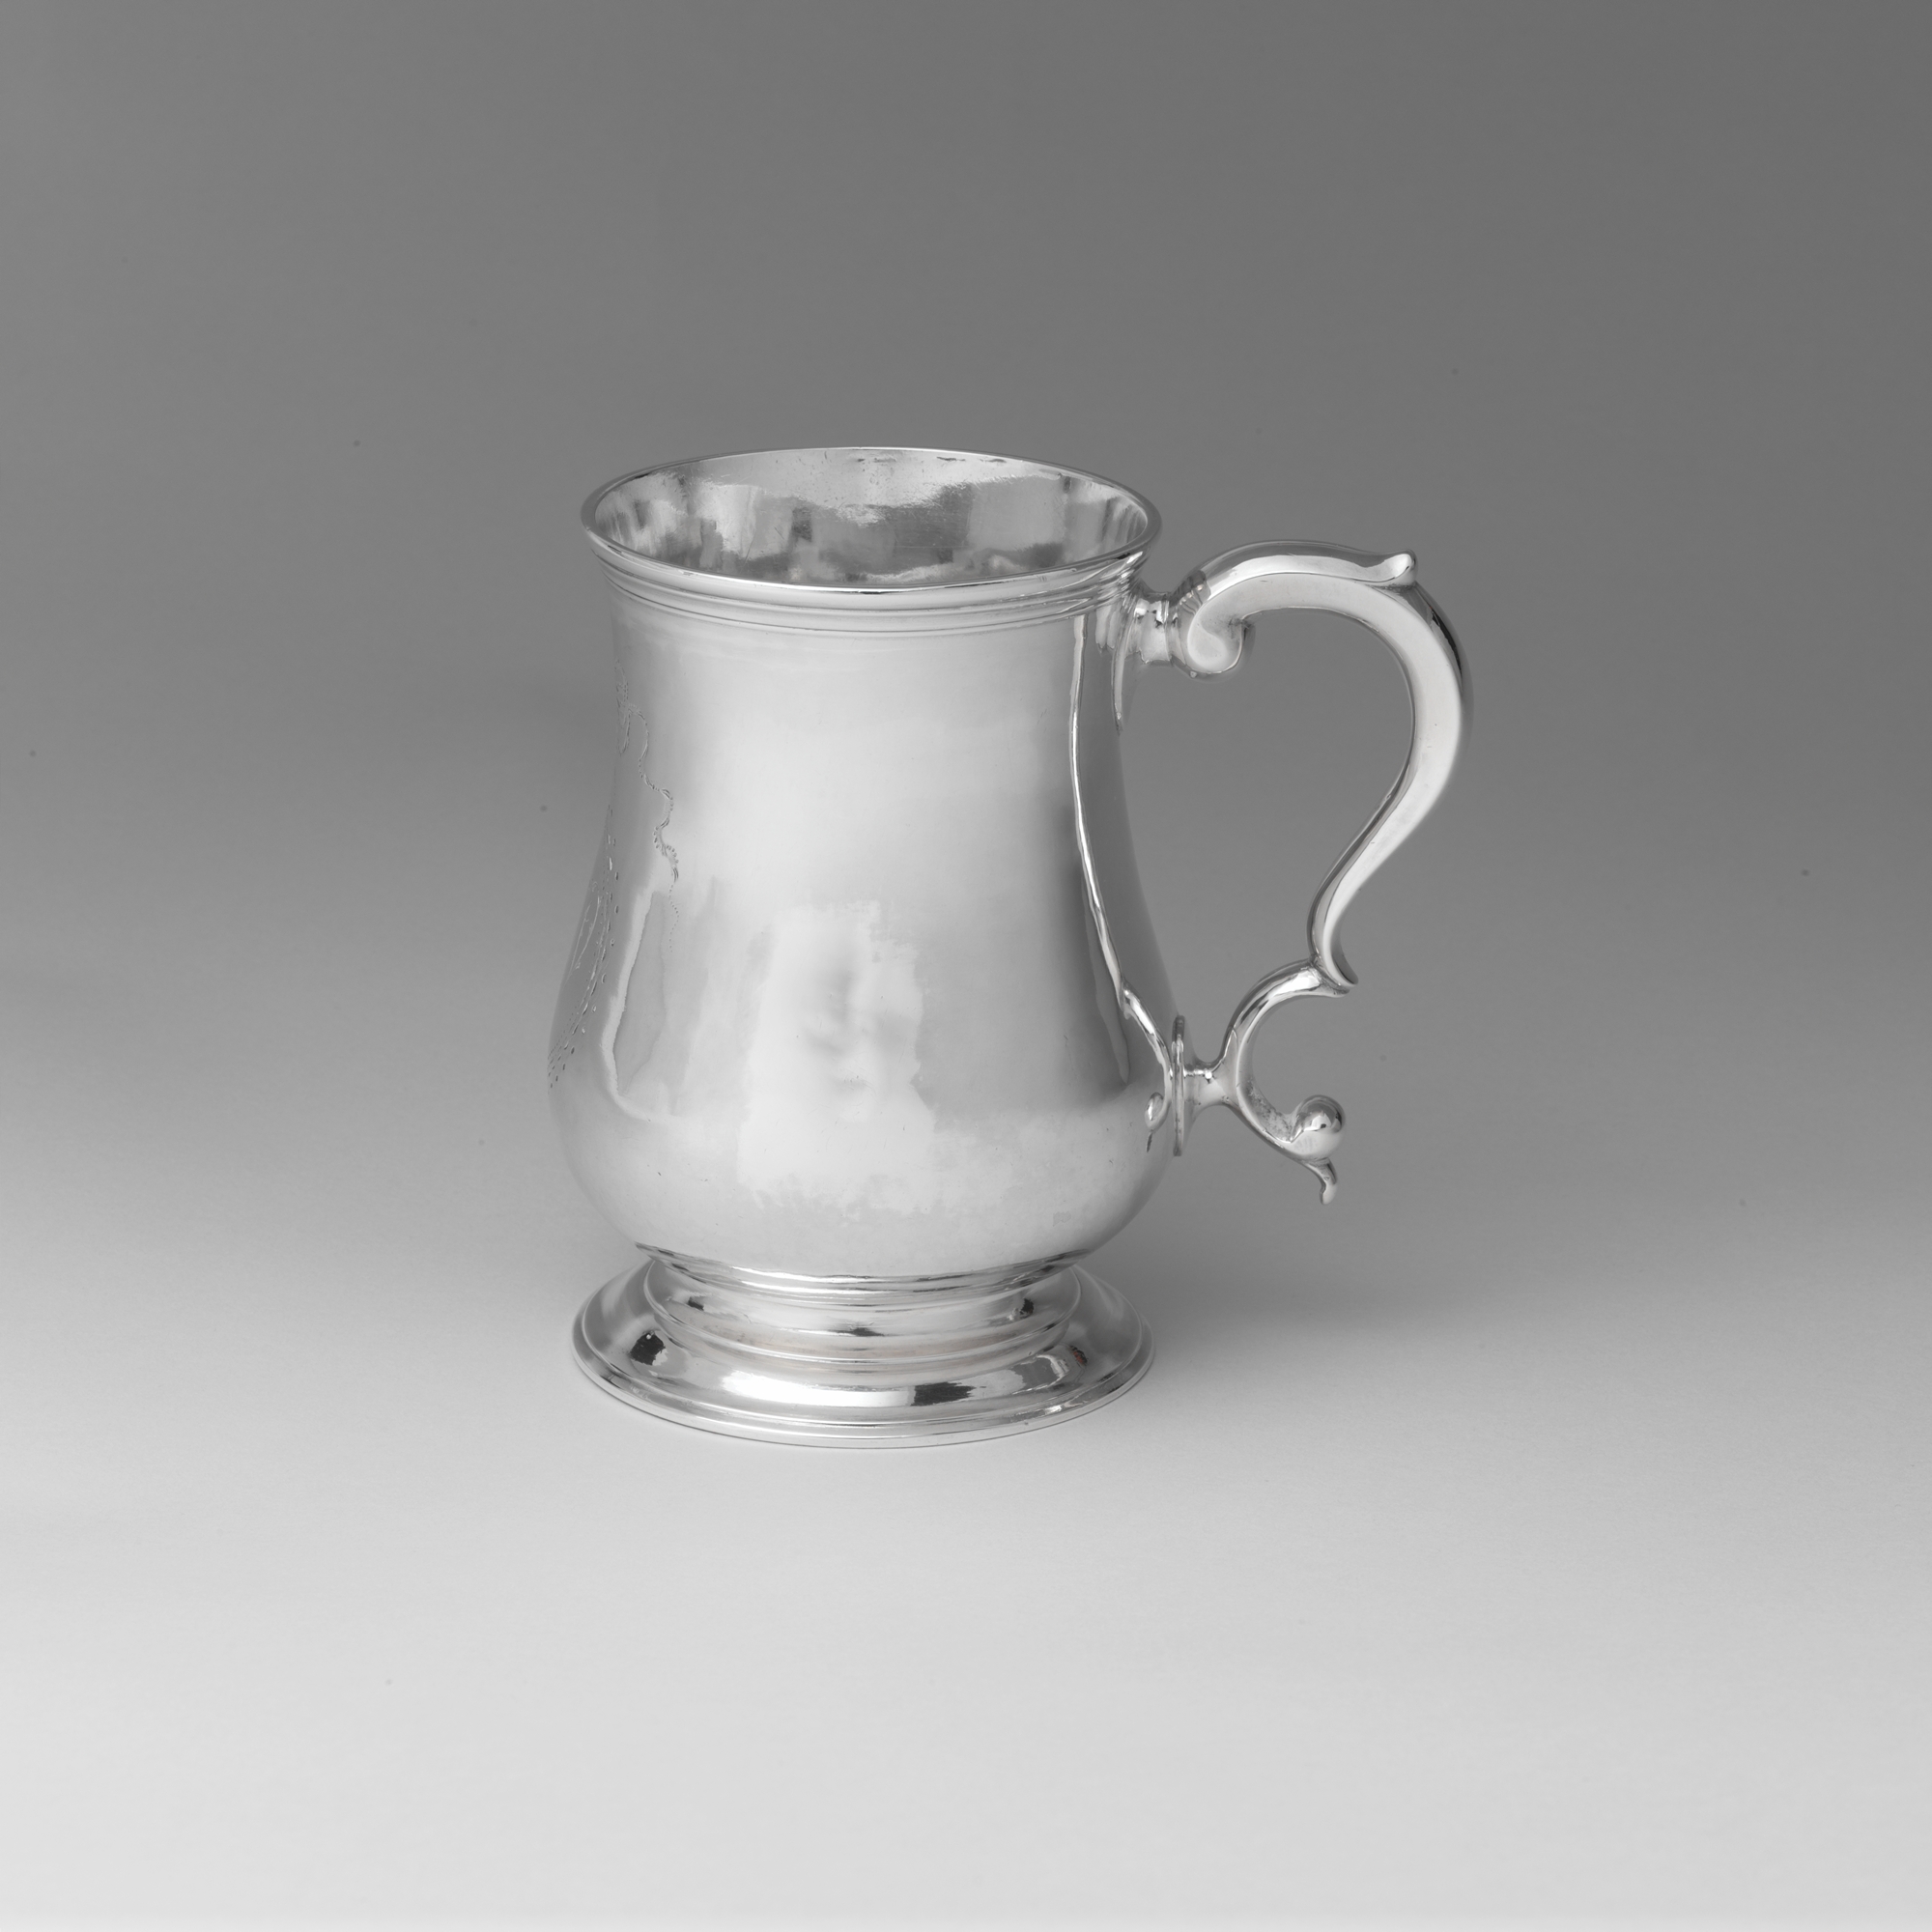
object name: cann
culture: american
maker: paul revere jr.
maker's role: maker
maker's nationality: american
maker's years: 1734-1818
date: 1770-1795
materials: silver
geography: united states